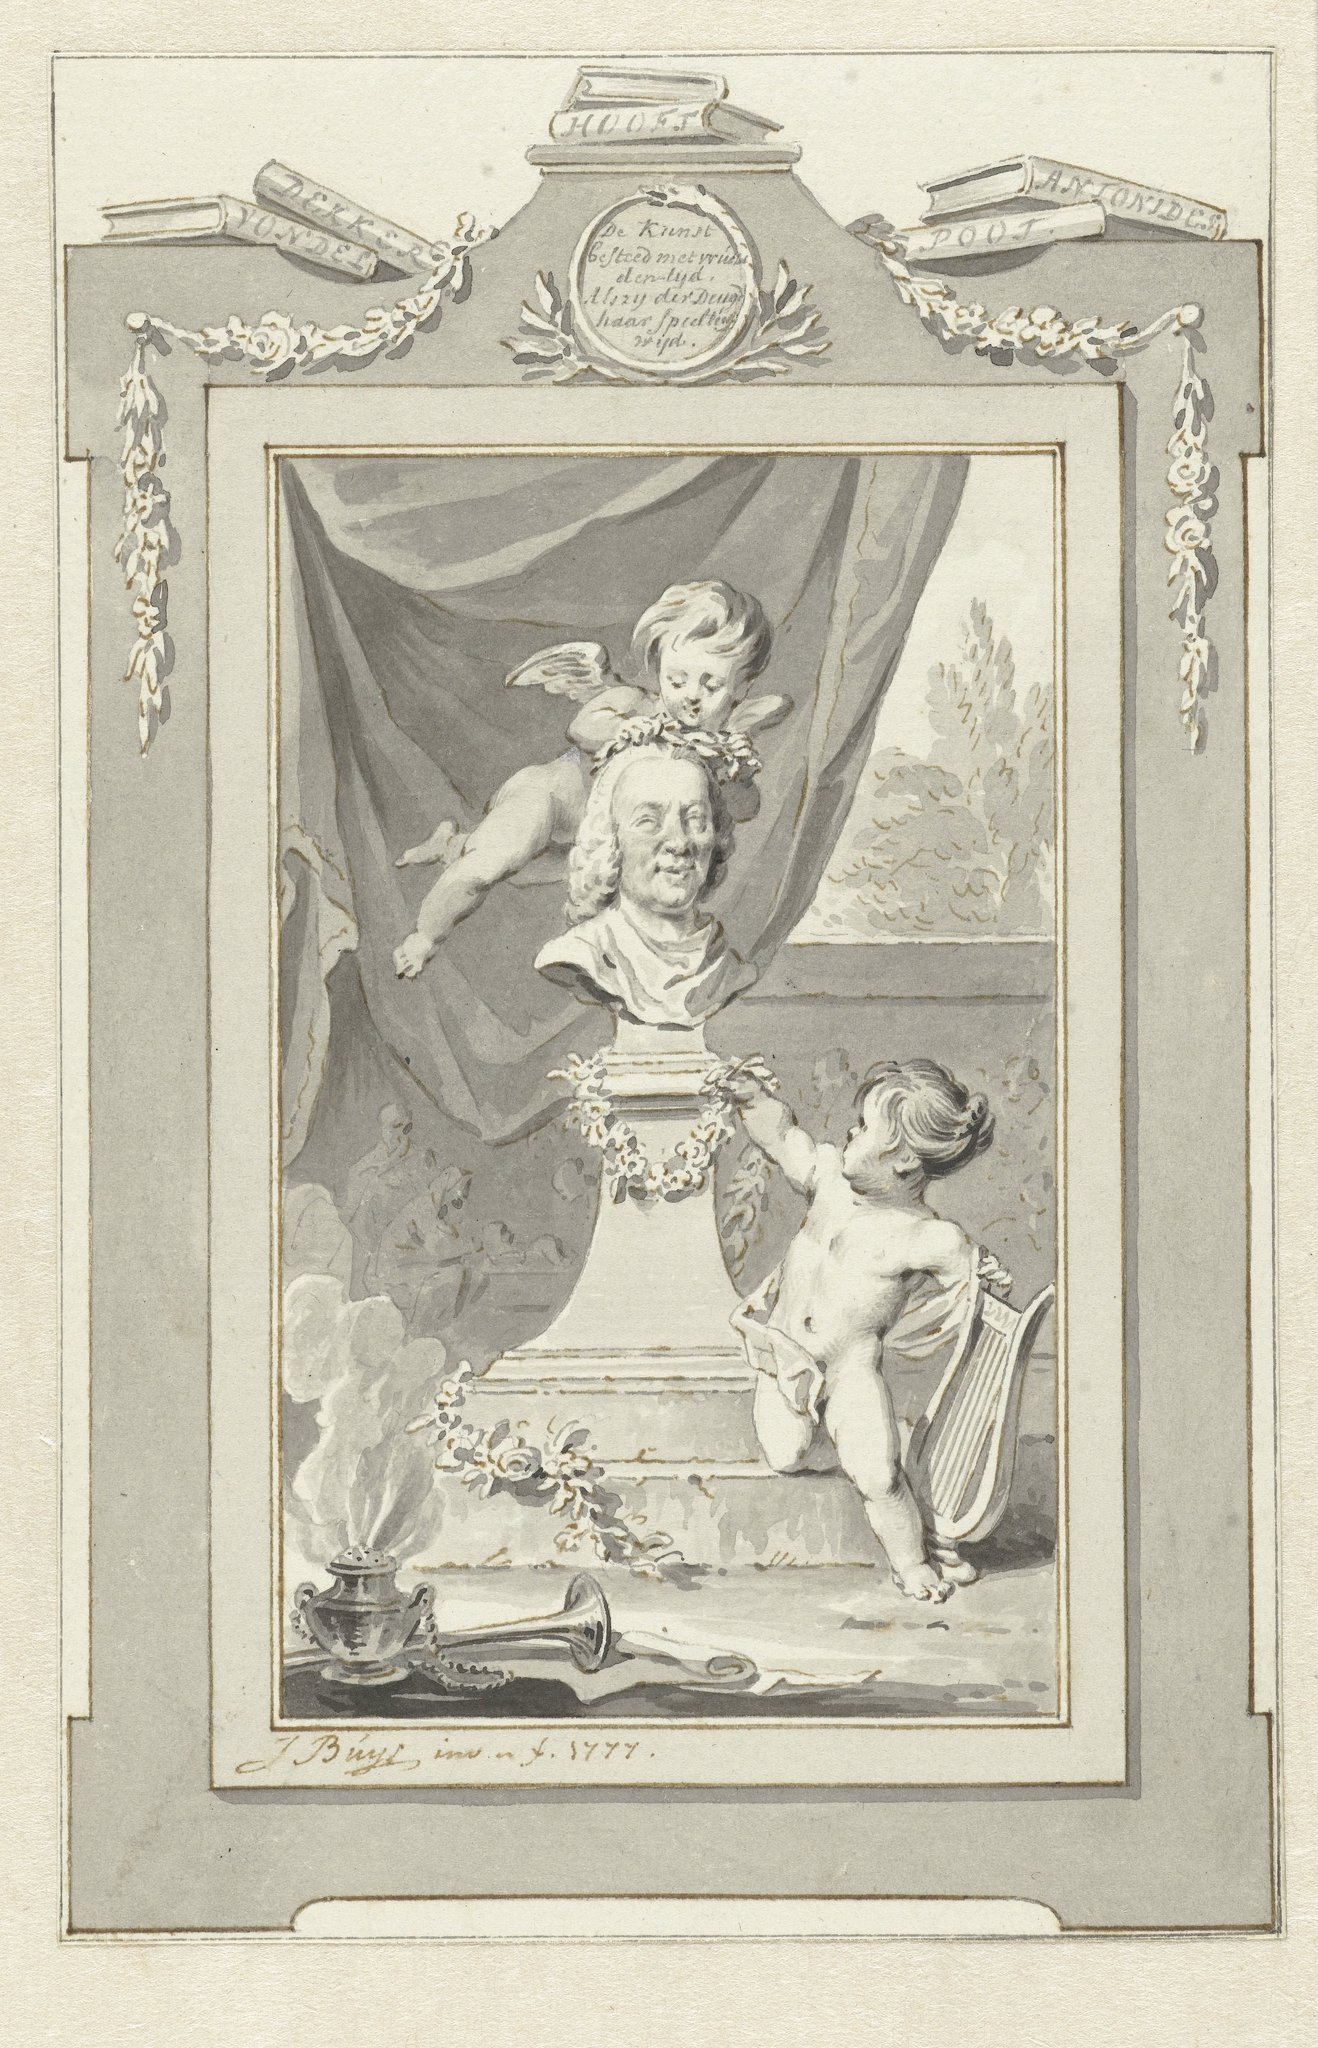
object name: design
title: Portretbuste van een dichter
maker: jacobus buys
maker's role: draughtsman, print maker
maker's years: 1724-1801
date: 1777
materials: ink, paper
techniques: brush, pen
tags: anonymous historical person portrayed alone, portrait of a writer, piece of sculpture, reproduction of a piece of sculpture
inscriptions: date: ‘1777’